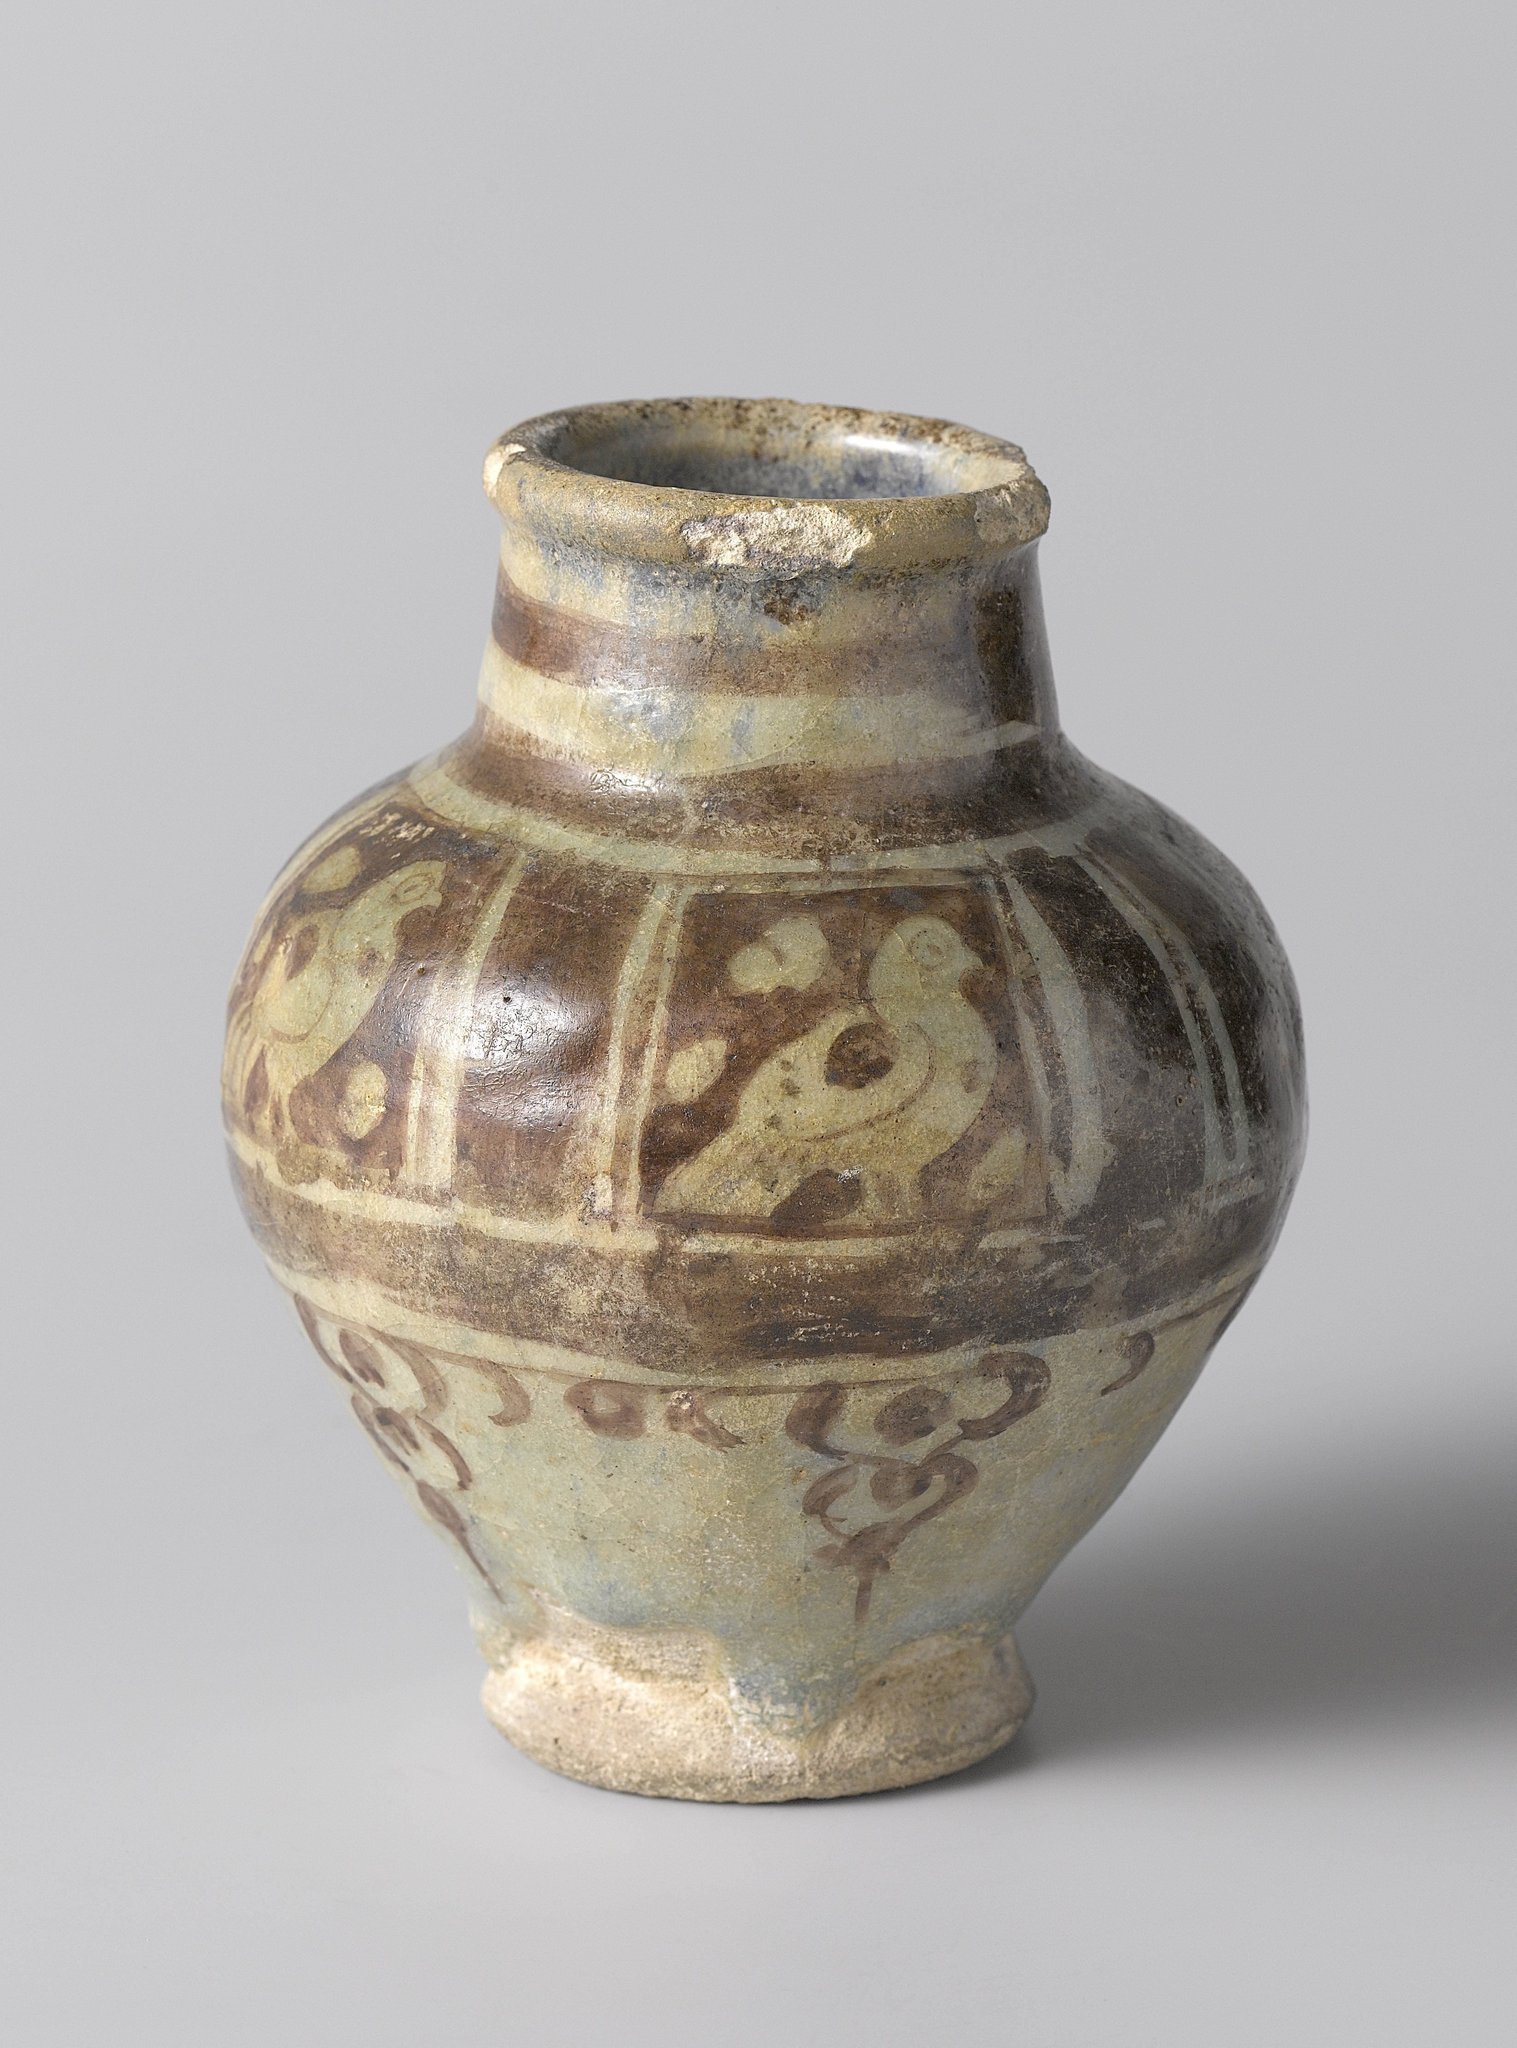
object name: vase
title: Ovoid vase with pigeons in a panel decoration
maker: Anonymous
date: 1170-1199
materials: earthenware, glaze, luster, paint, quartz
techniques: firing, turning, vitrification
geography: kashan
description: Vaas van kwarts-fritgoed gedecoreerd met duiven in vakken en ranken in bruin luster op ondergrond van transparant alkaliglazuur.